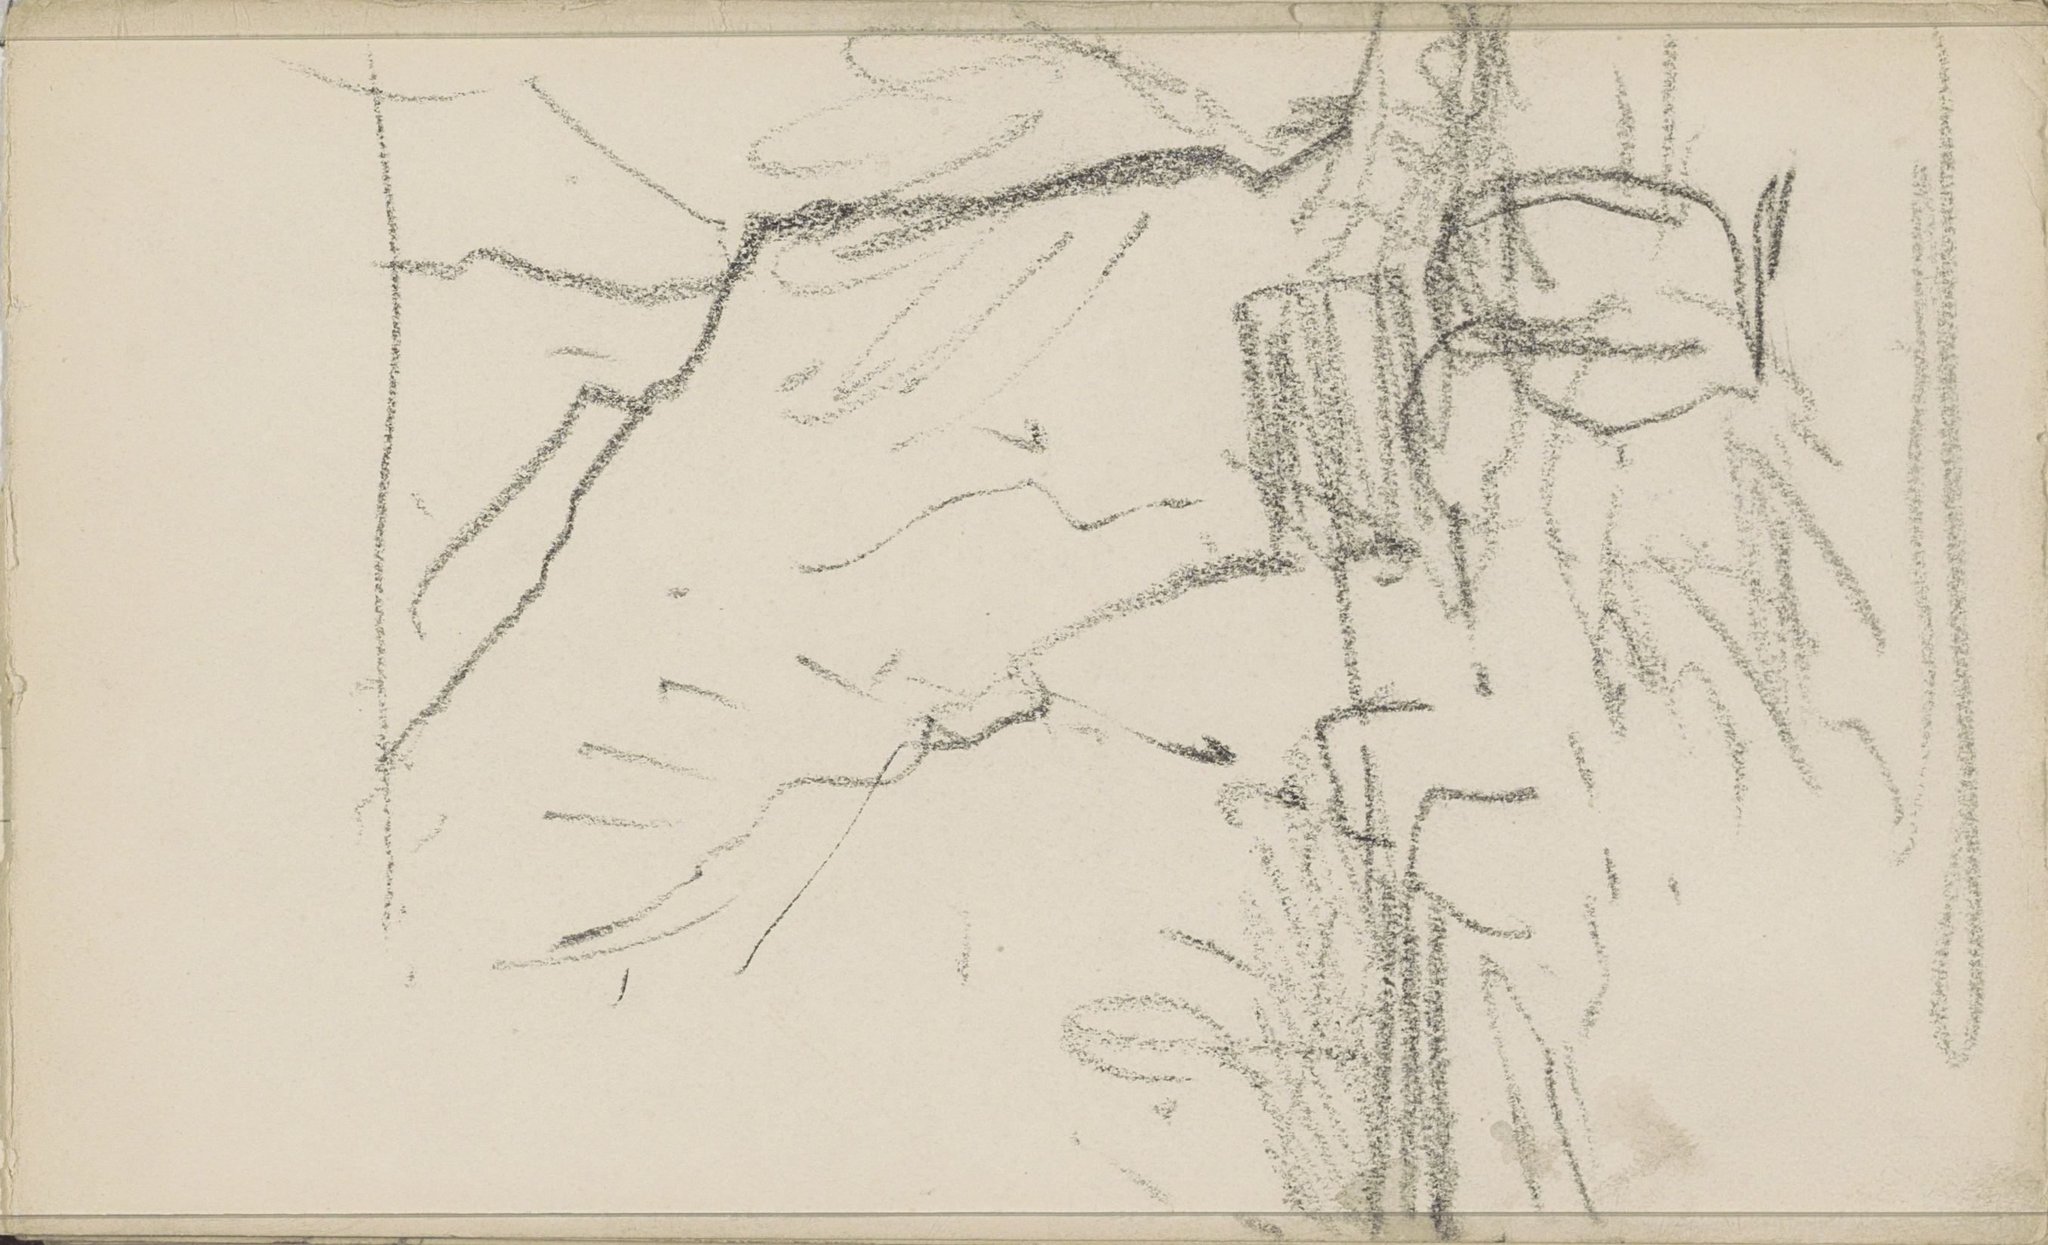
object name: sketchbook leaf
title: Landschap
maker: anton mauve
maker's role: draughtsman, painter, print maker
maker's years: 1838-1888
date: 1848-1888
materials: chalk, paper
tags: landscapes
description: Blad 4 recto uit een schetsboek met 33 bladen.